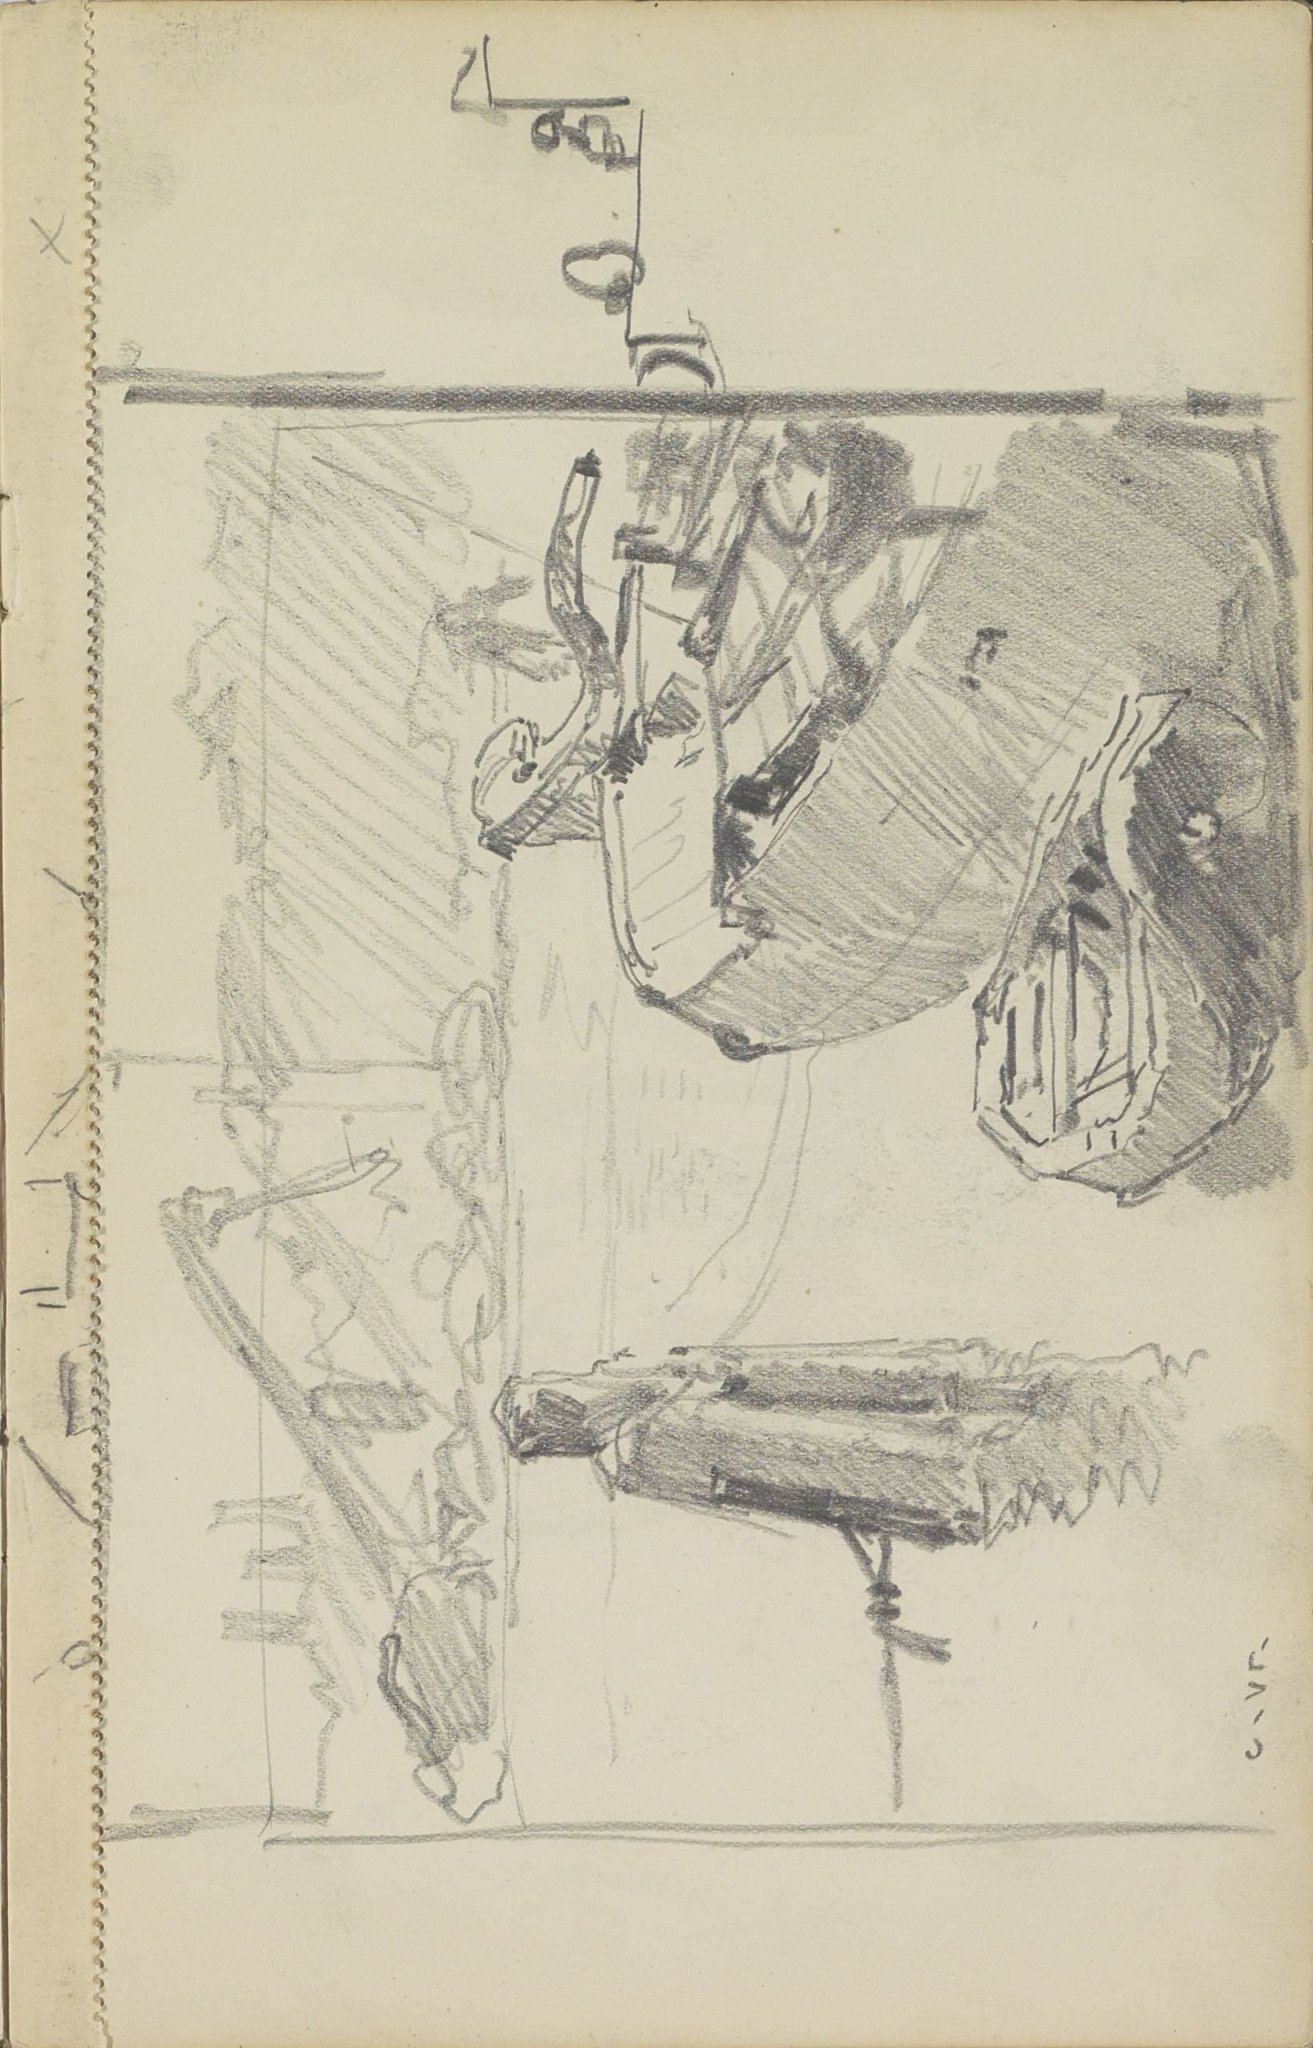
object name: sketchbook leaf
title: Zeilboot bij een aanlegpaal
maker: cornelis vreedenburgh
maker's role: draughtsman, print maker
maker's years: 1880-1946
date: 1890-1946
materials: paper, pencil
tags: sailing-ship, sailing-boat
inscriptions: signature: ‘c.vr.’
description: Blad 2 recto uit een schetsboek met 56 bladen.